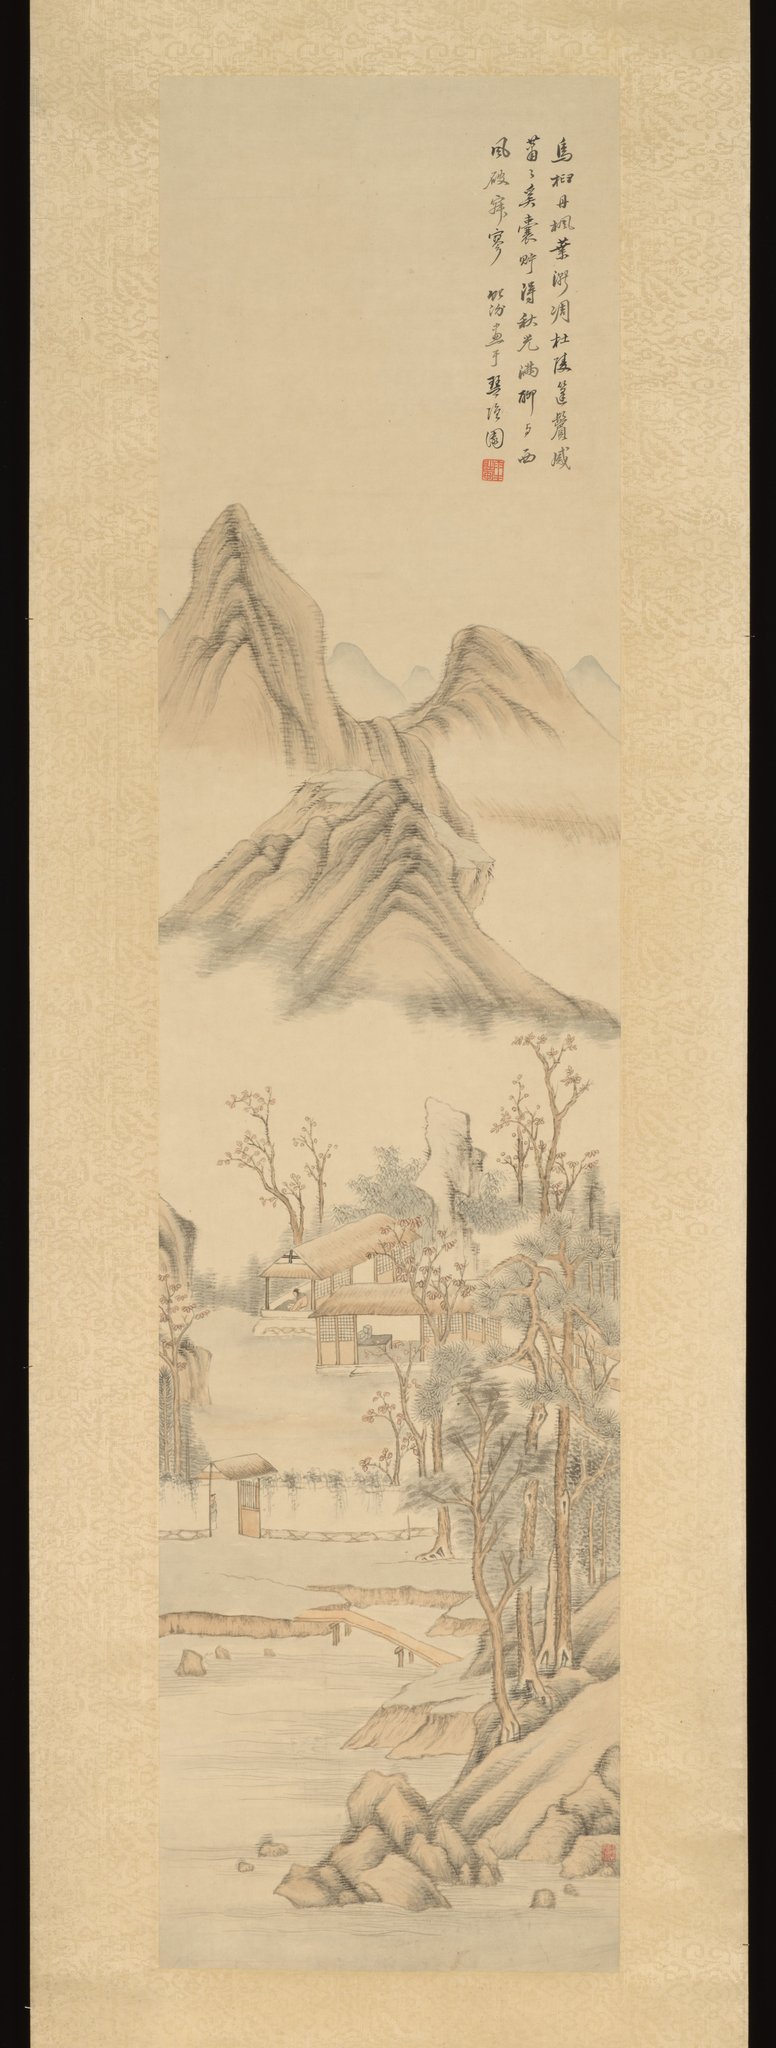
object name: hanging scroll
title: Landscape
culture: chinese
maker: tang yifen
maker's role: artist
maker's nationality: chinese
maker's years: 1778-1853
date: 1778-1853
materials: ink, paper